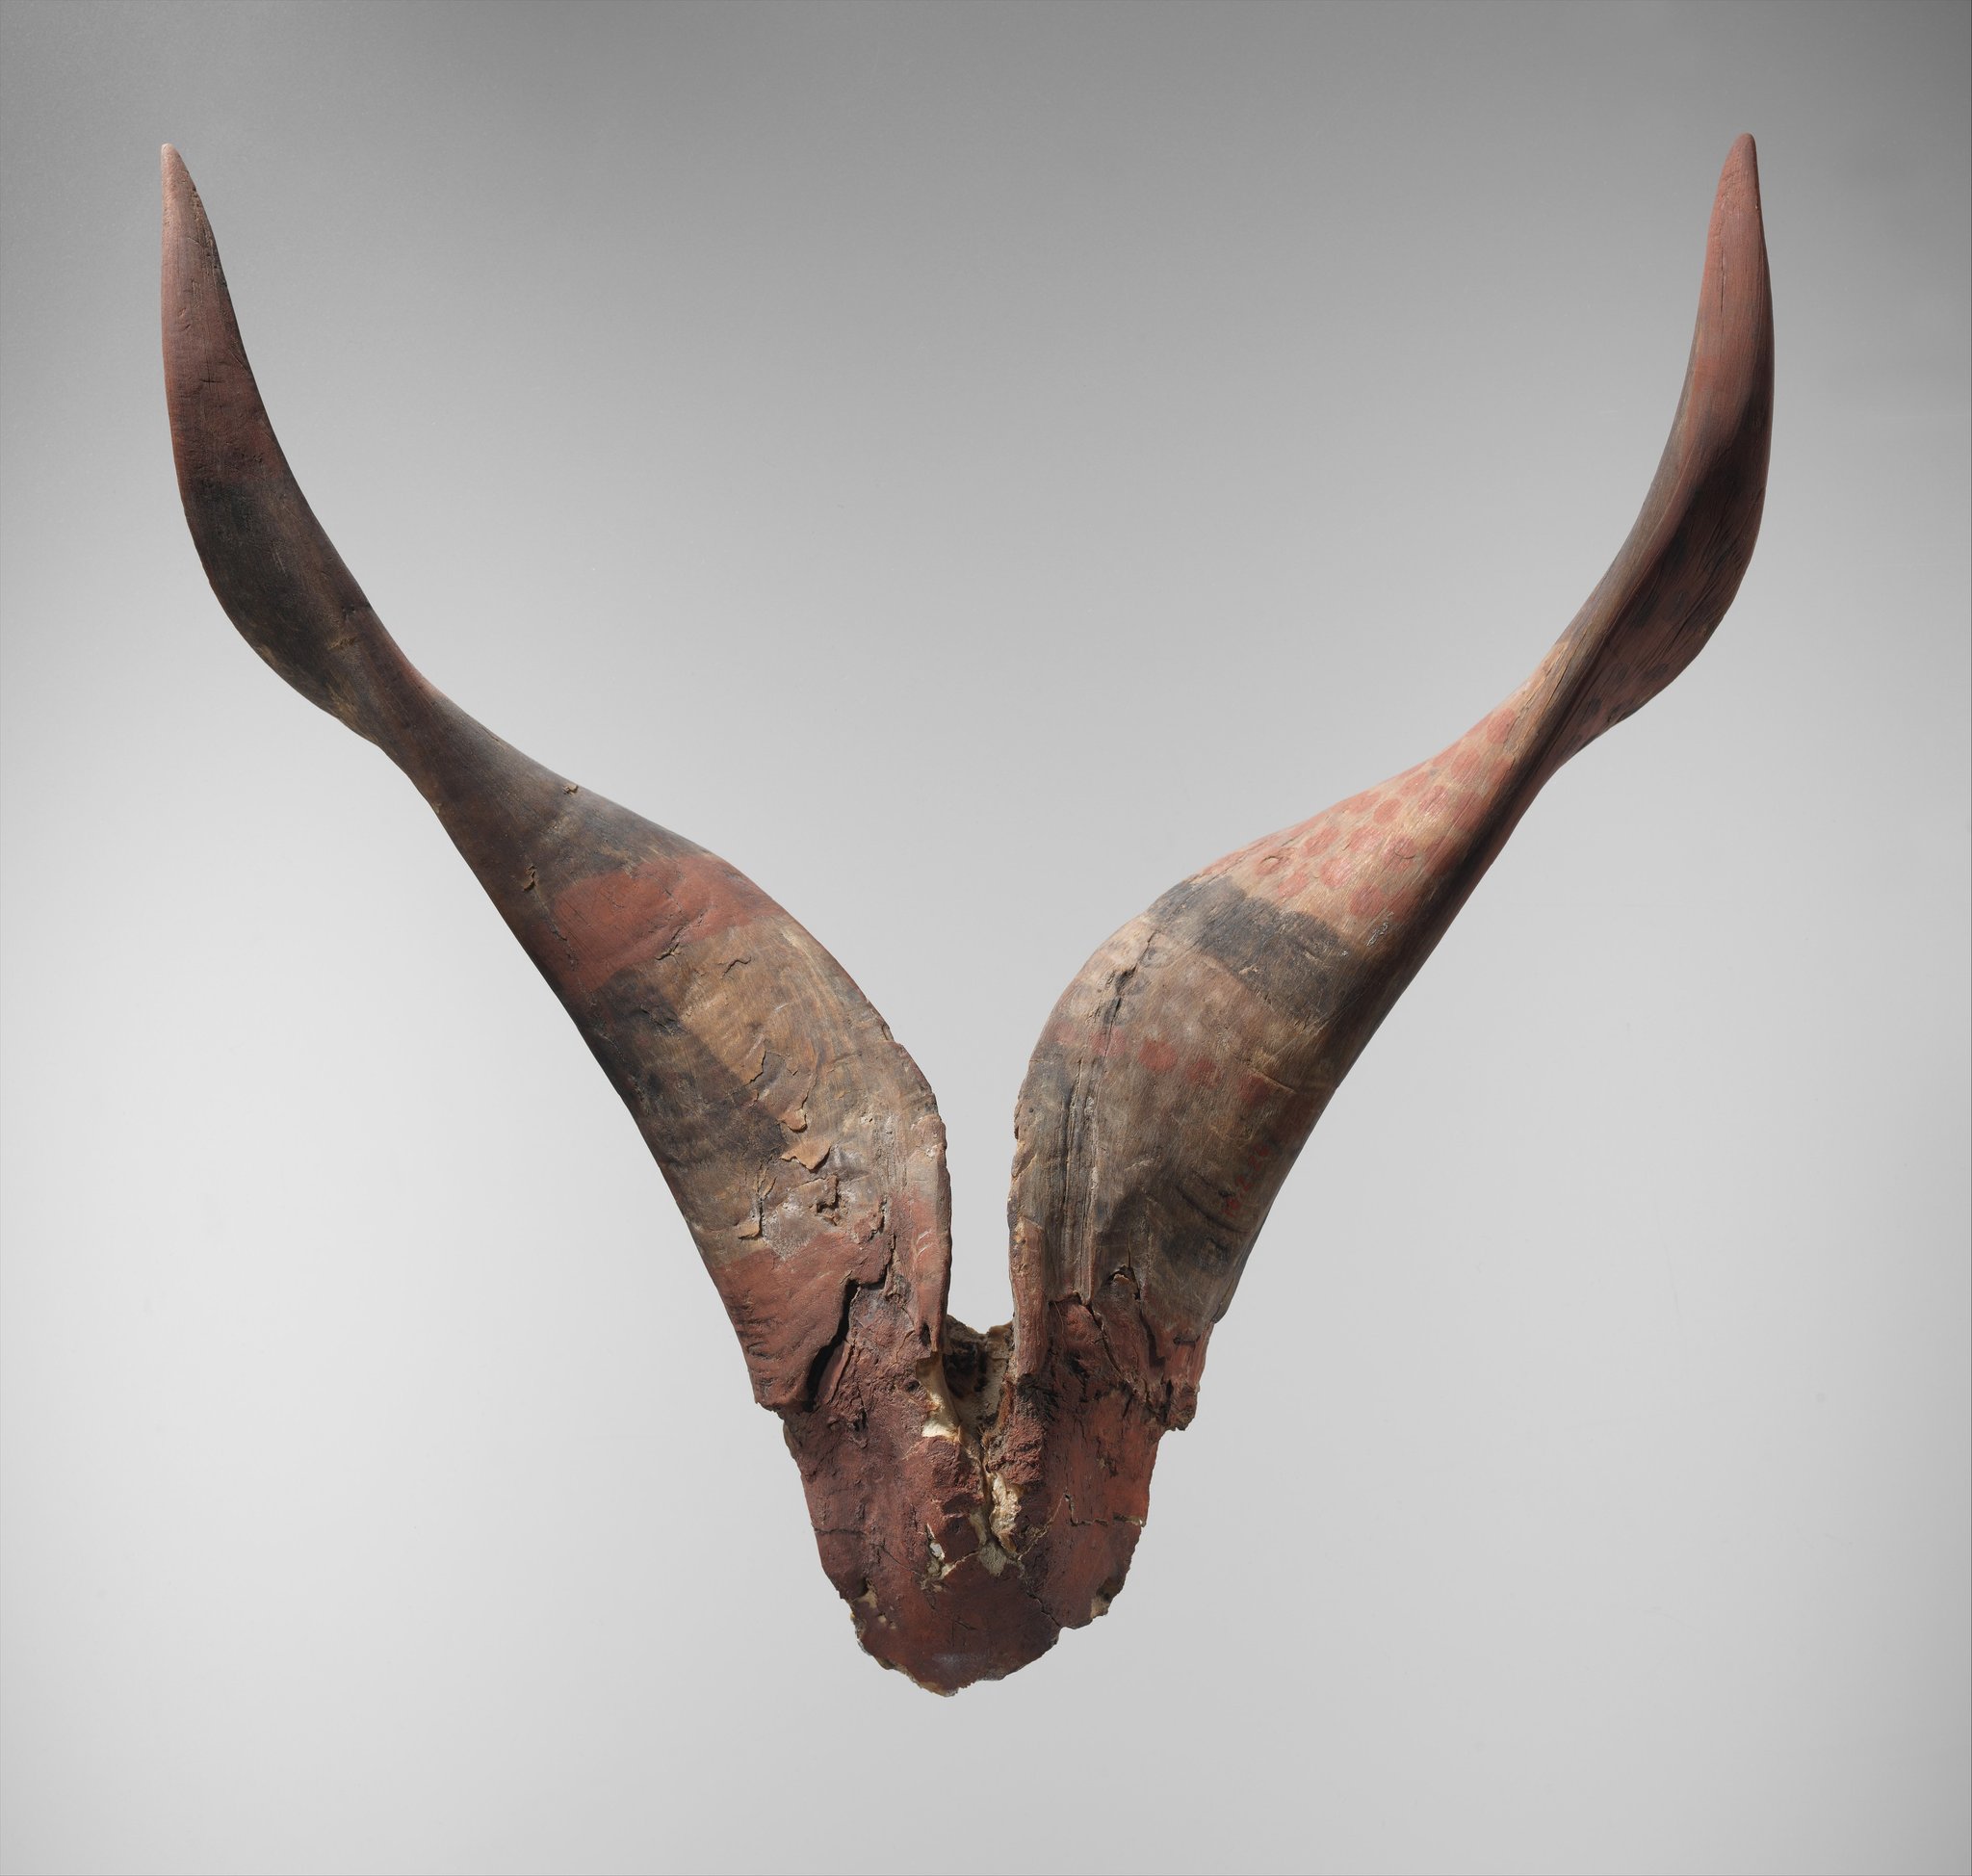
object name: bucranium, antler, horn, pan grave, medjayu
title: Bucranium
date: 1640-1550 BCE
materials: antler, bone, paint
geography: egypt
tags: animals,skulls